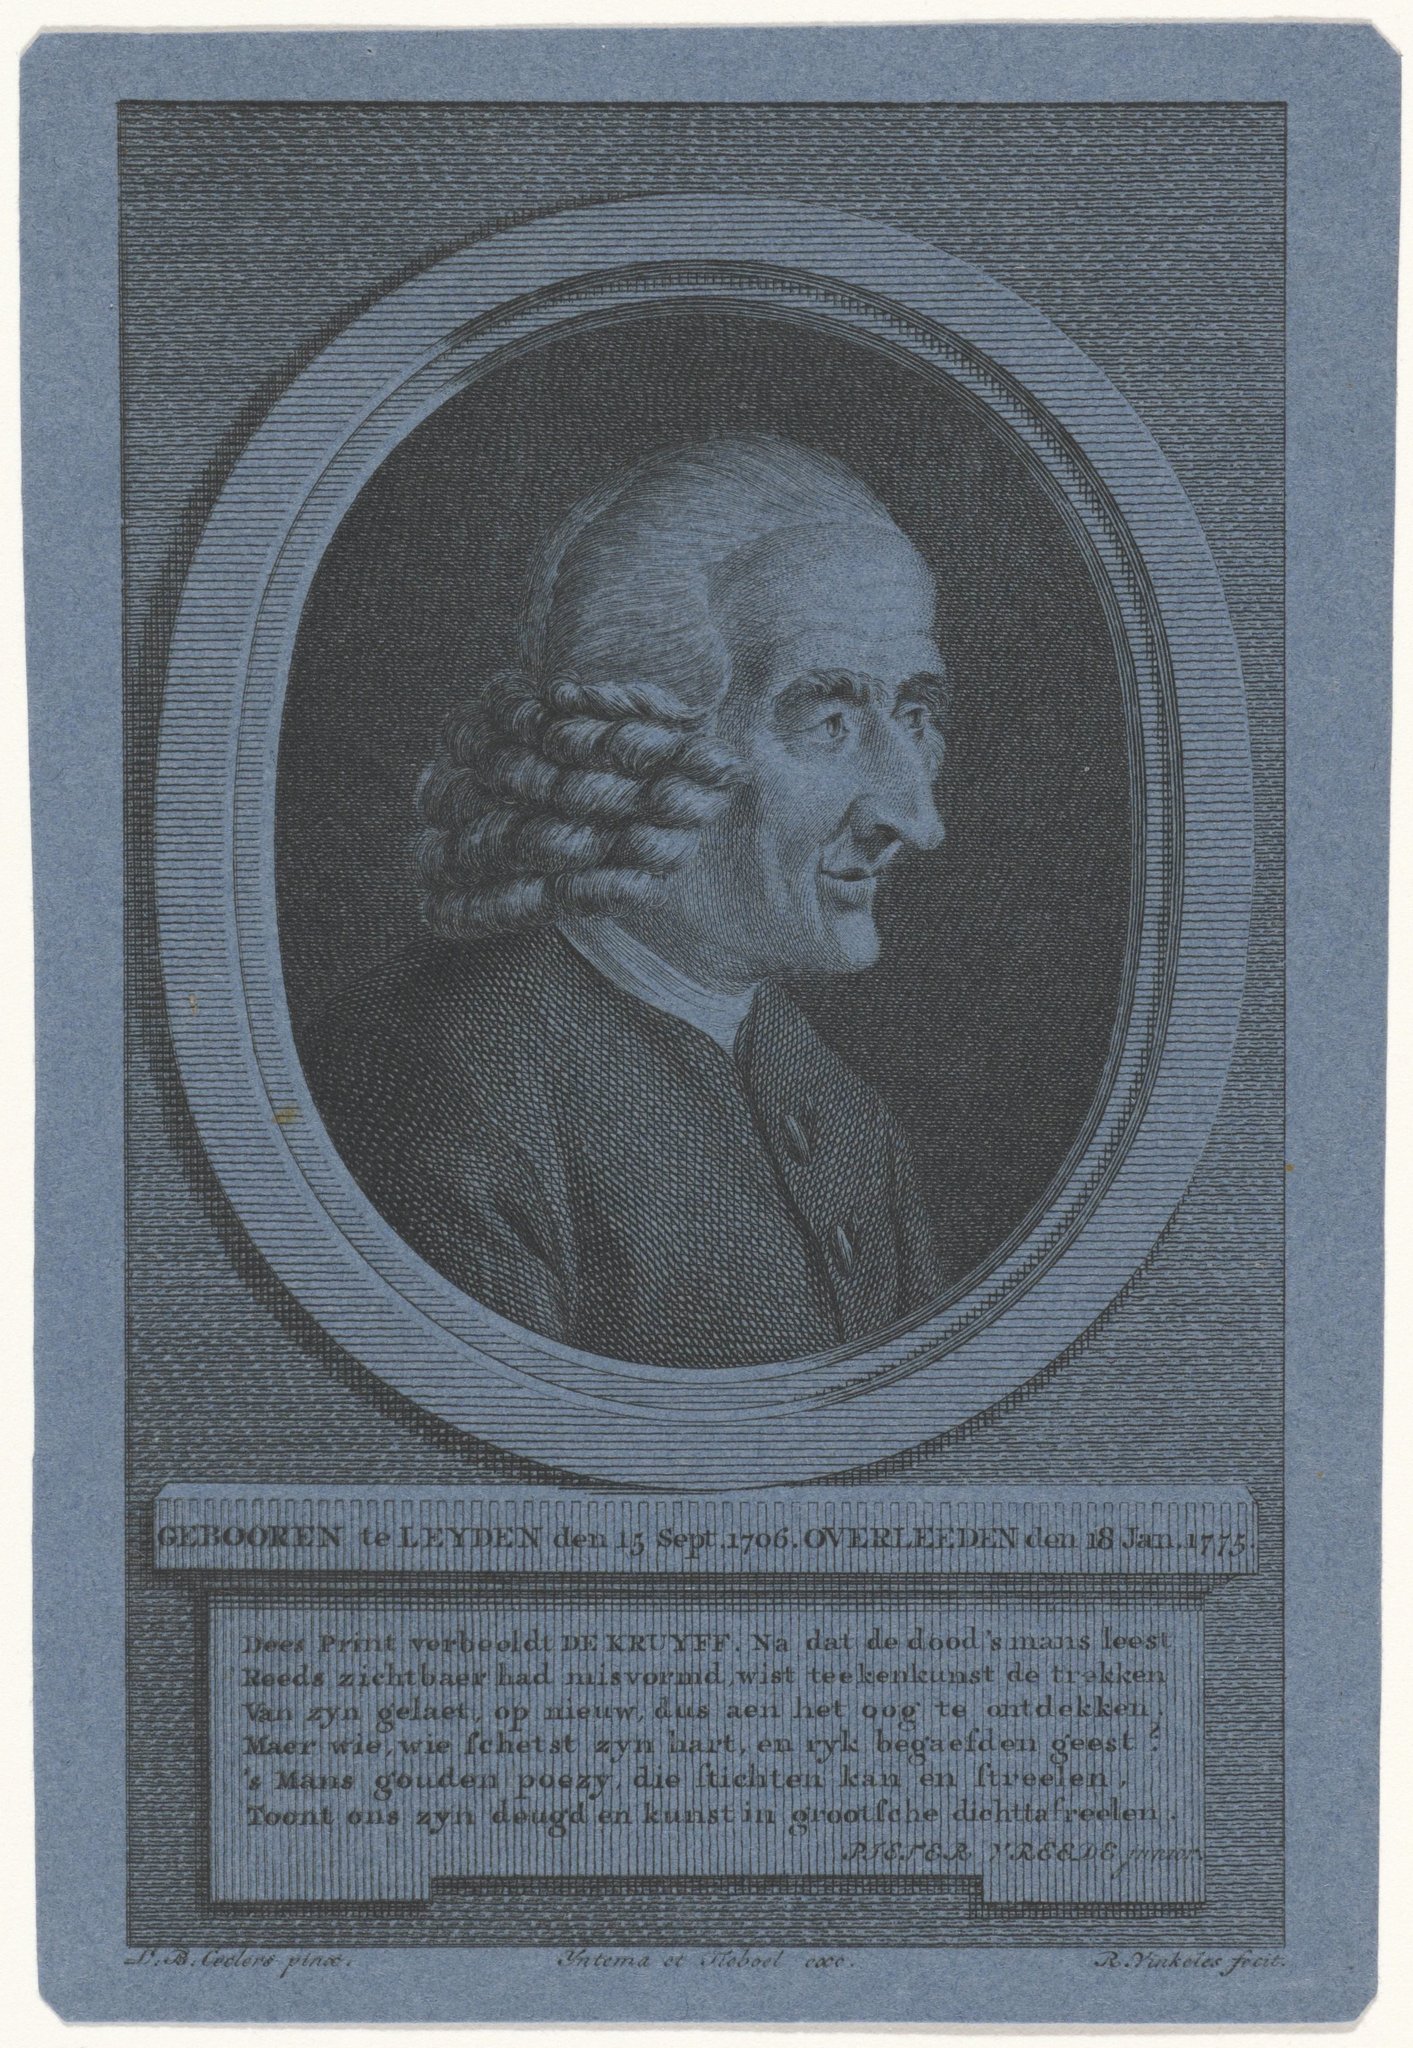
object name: print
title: Portret van de Nederlandse dichter Jan de Kruyff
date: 1775-1784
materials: paper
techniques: engraving, etching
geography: amsterdam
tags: leiden, jan de kruyff (1706-1775)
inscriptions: collector's mark: Lugt 2228